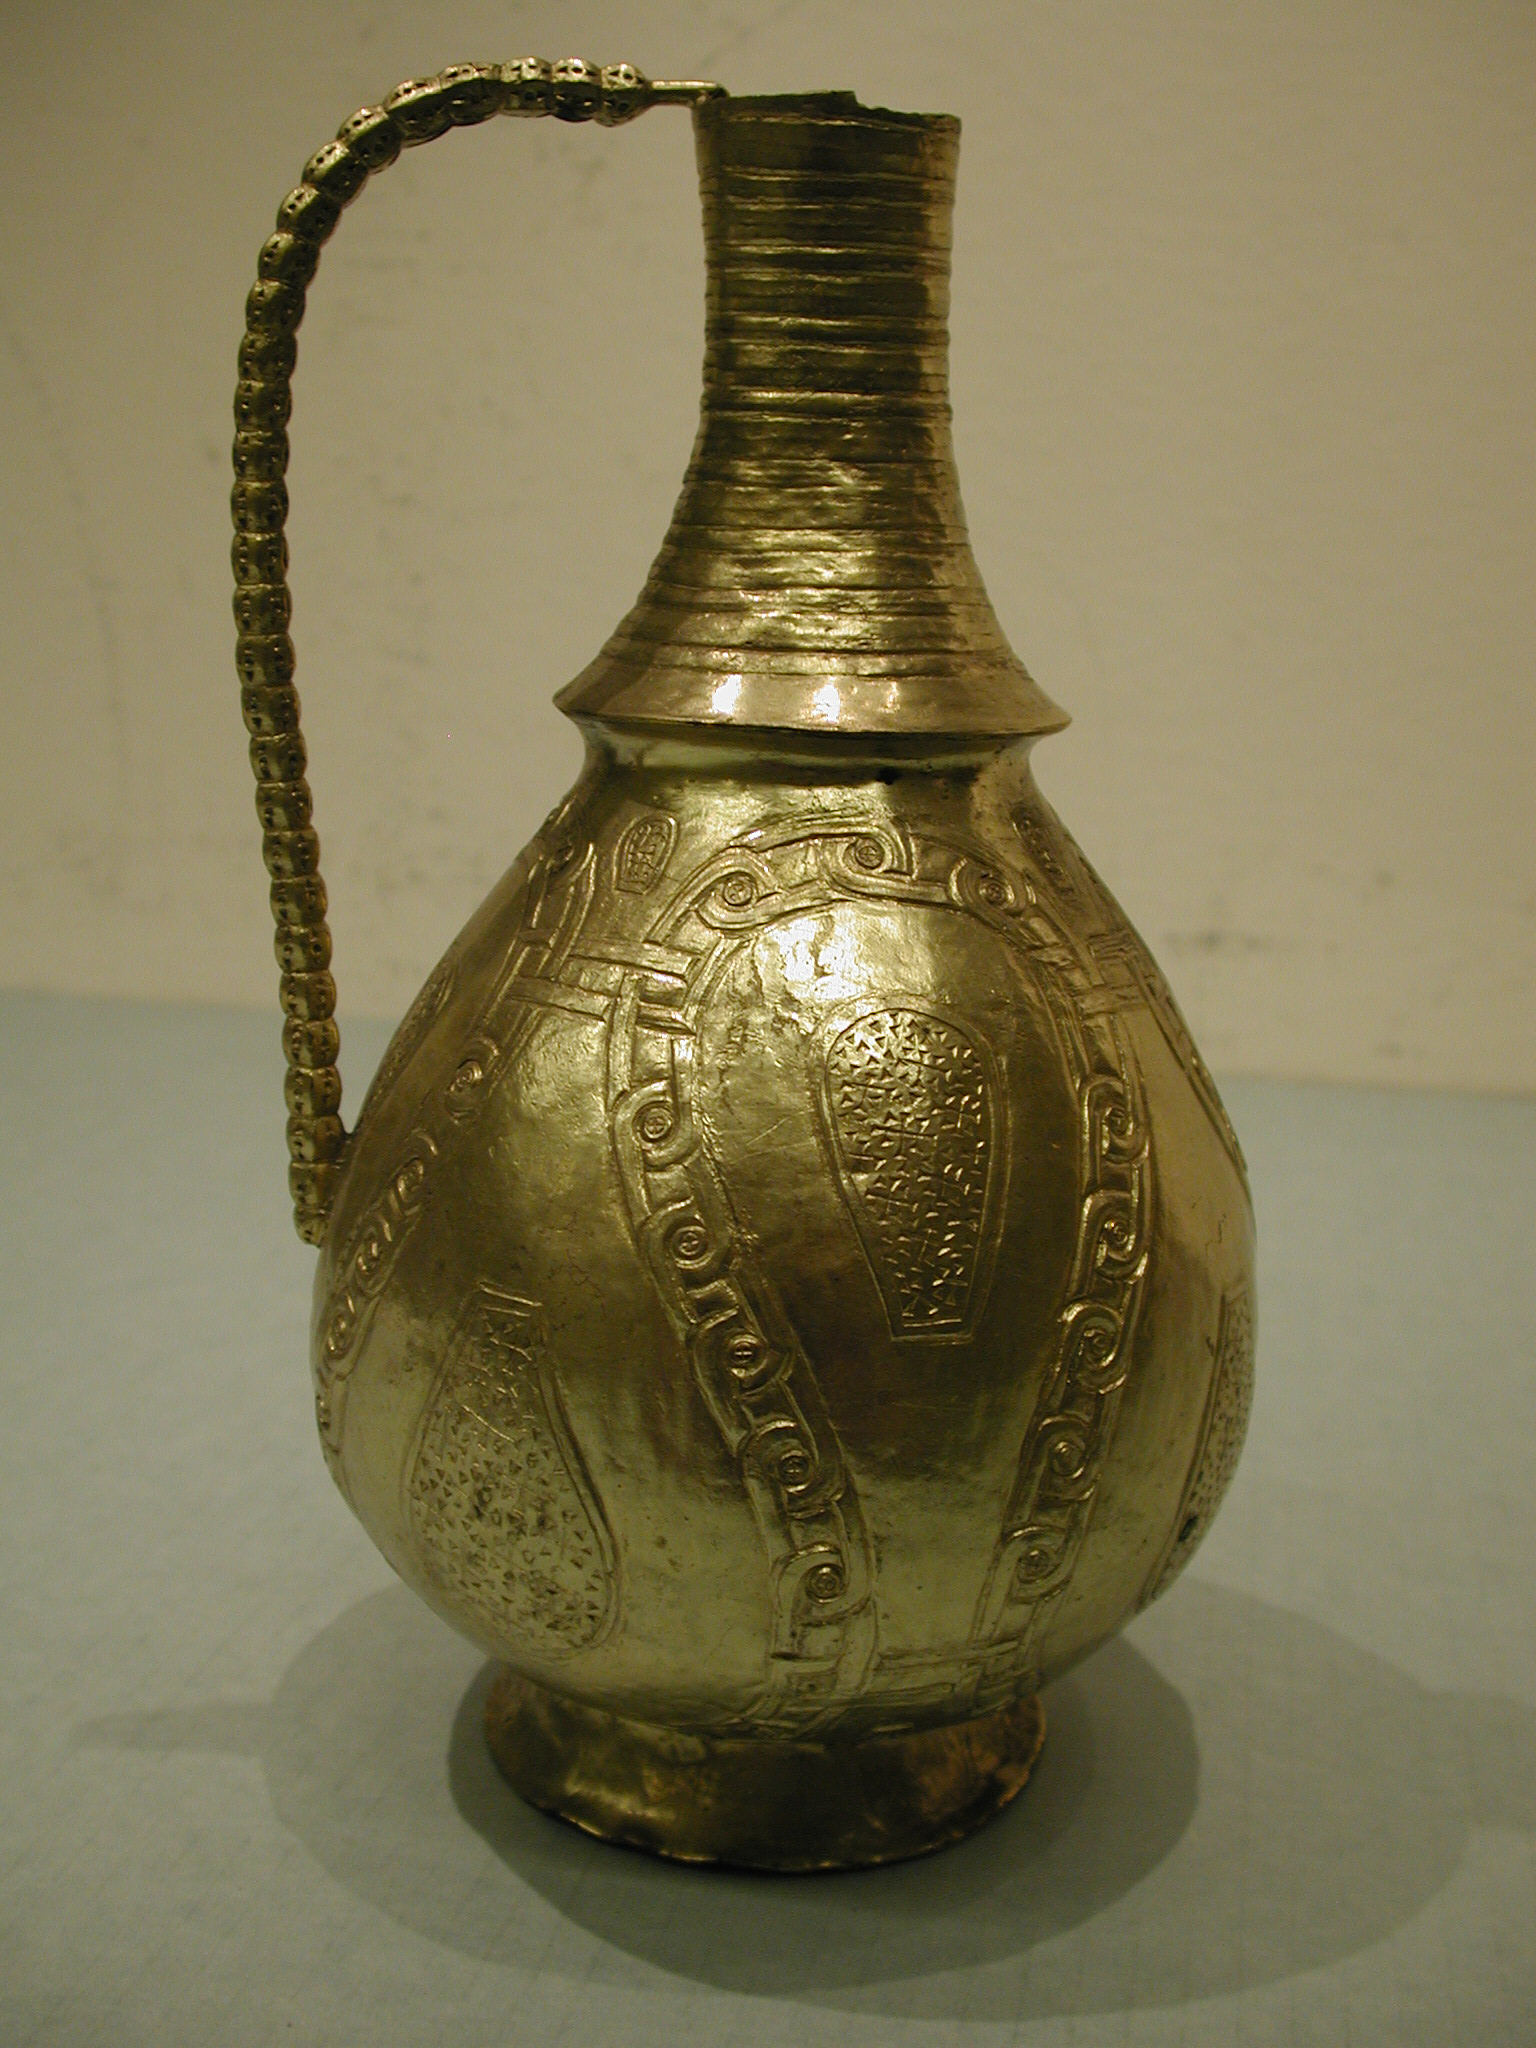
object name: ewer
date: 1801-1900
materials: metal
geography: hungary